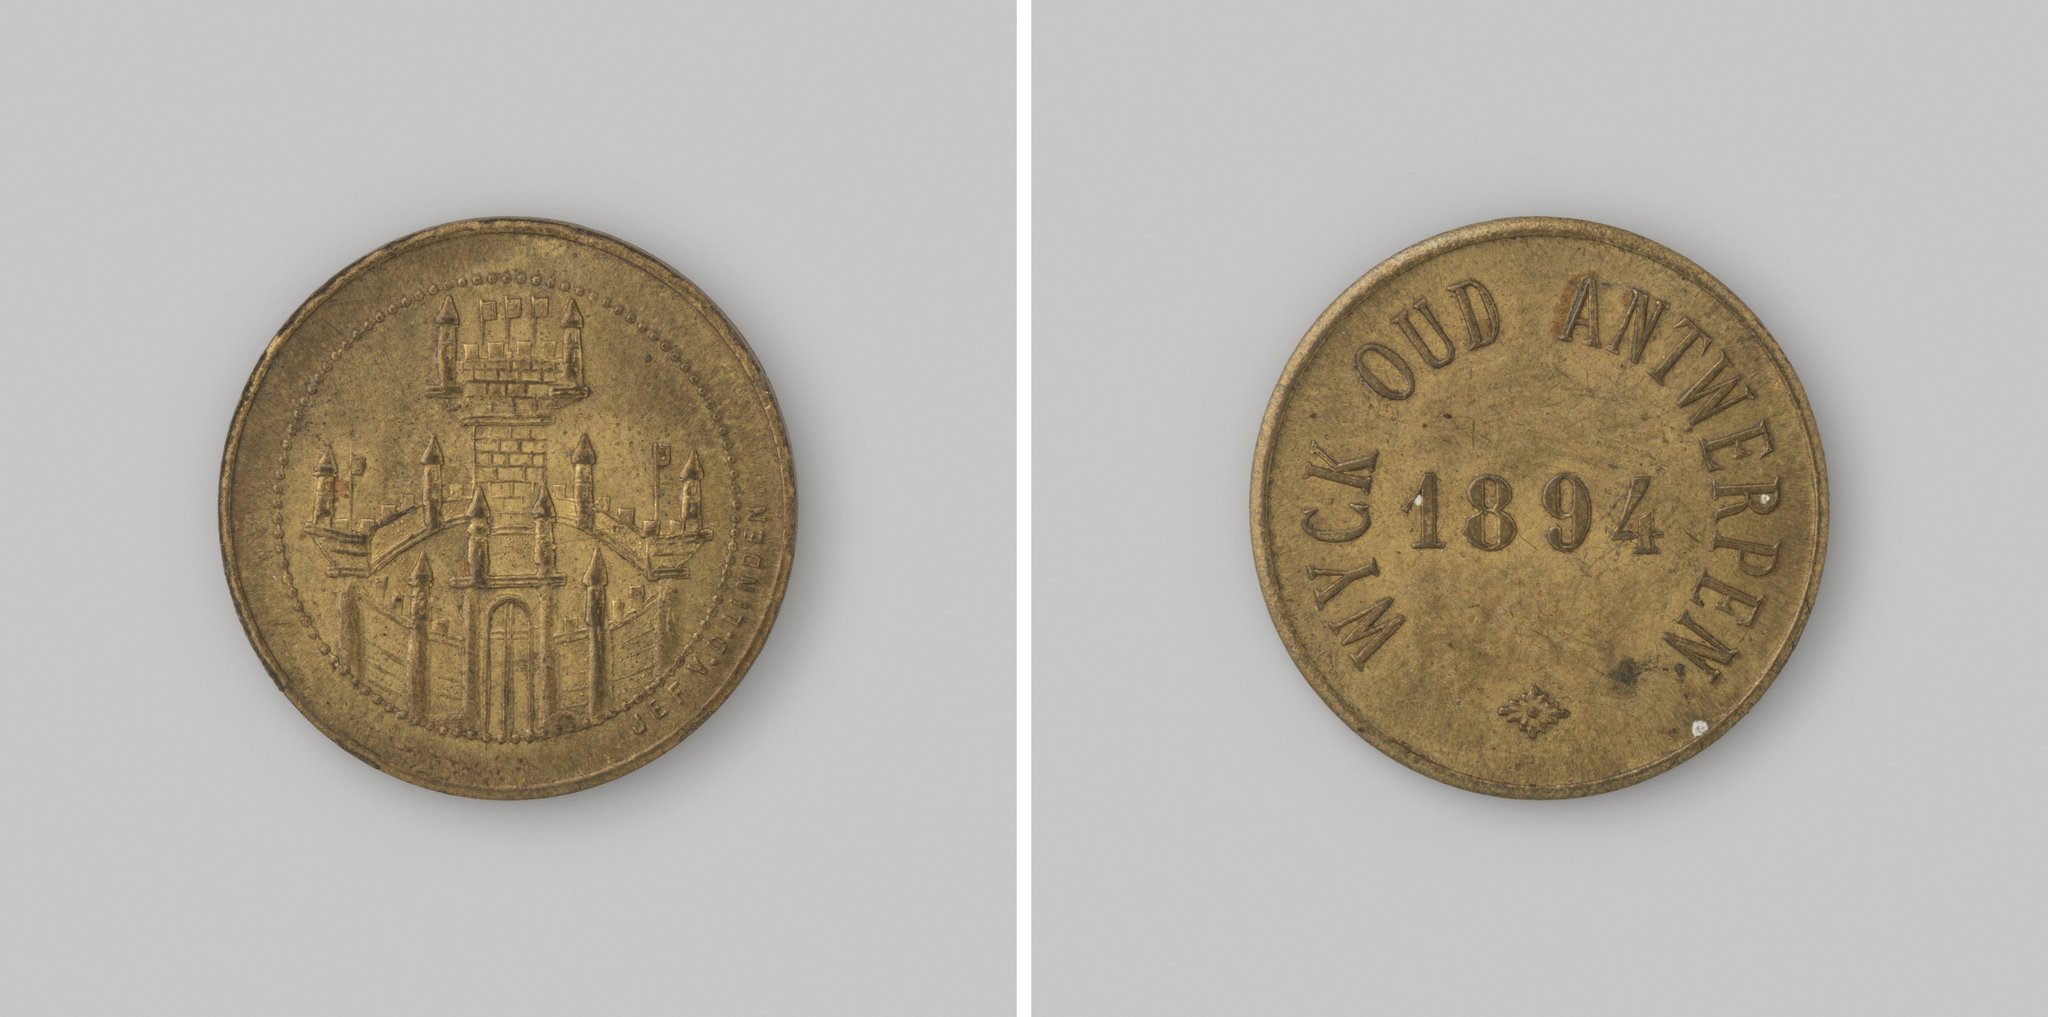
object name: history medal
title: Wereldtentoonstelling te Antwerpen (Wyck Oud Antwerpen) 1894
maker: jef van der linden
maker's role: designer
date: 1894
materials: brass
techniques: striking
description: Messing penning, op de voorzijde een ronde burcht met hoofdtoren binnen een cirkel, op de keerzijde het jaartal 1894 met omschrift.